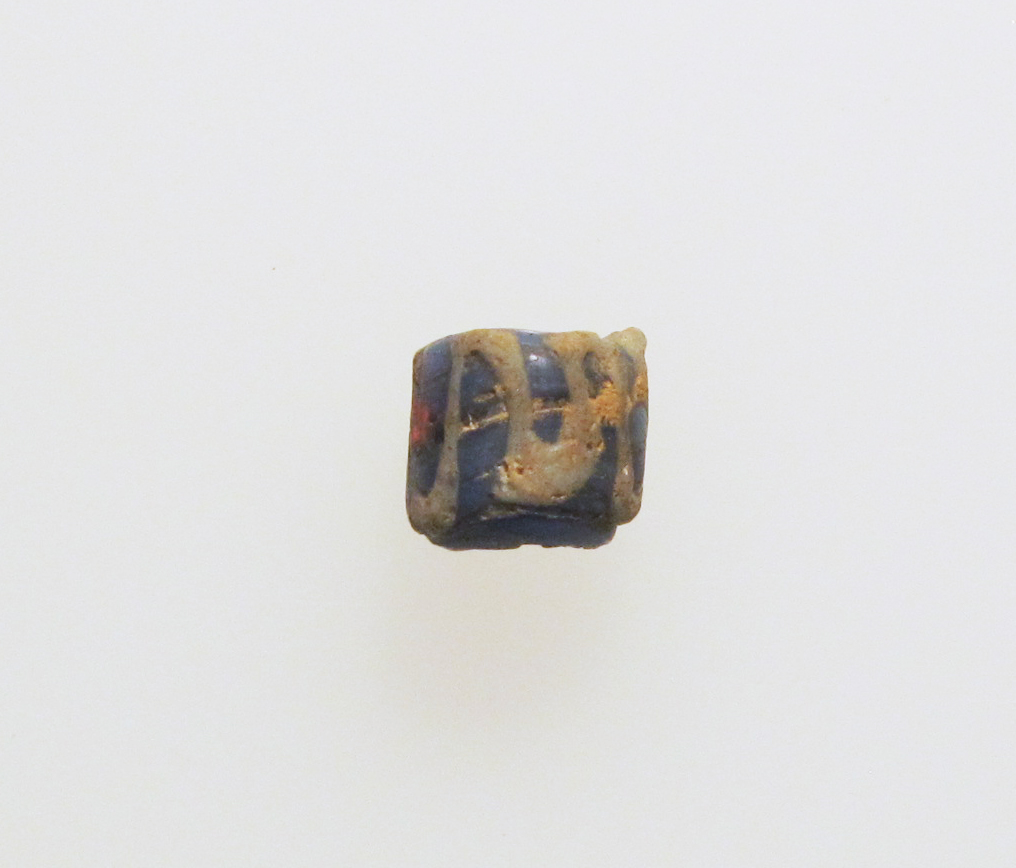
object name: bead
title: Glass bead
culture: roman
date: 101-400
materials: glass